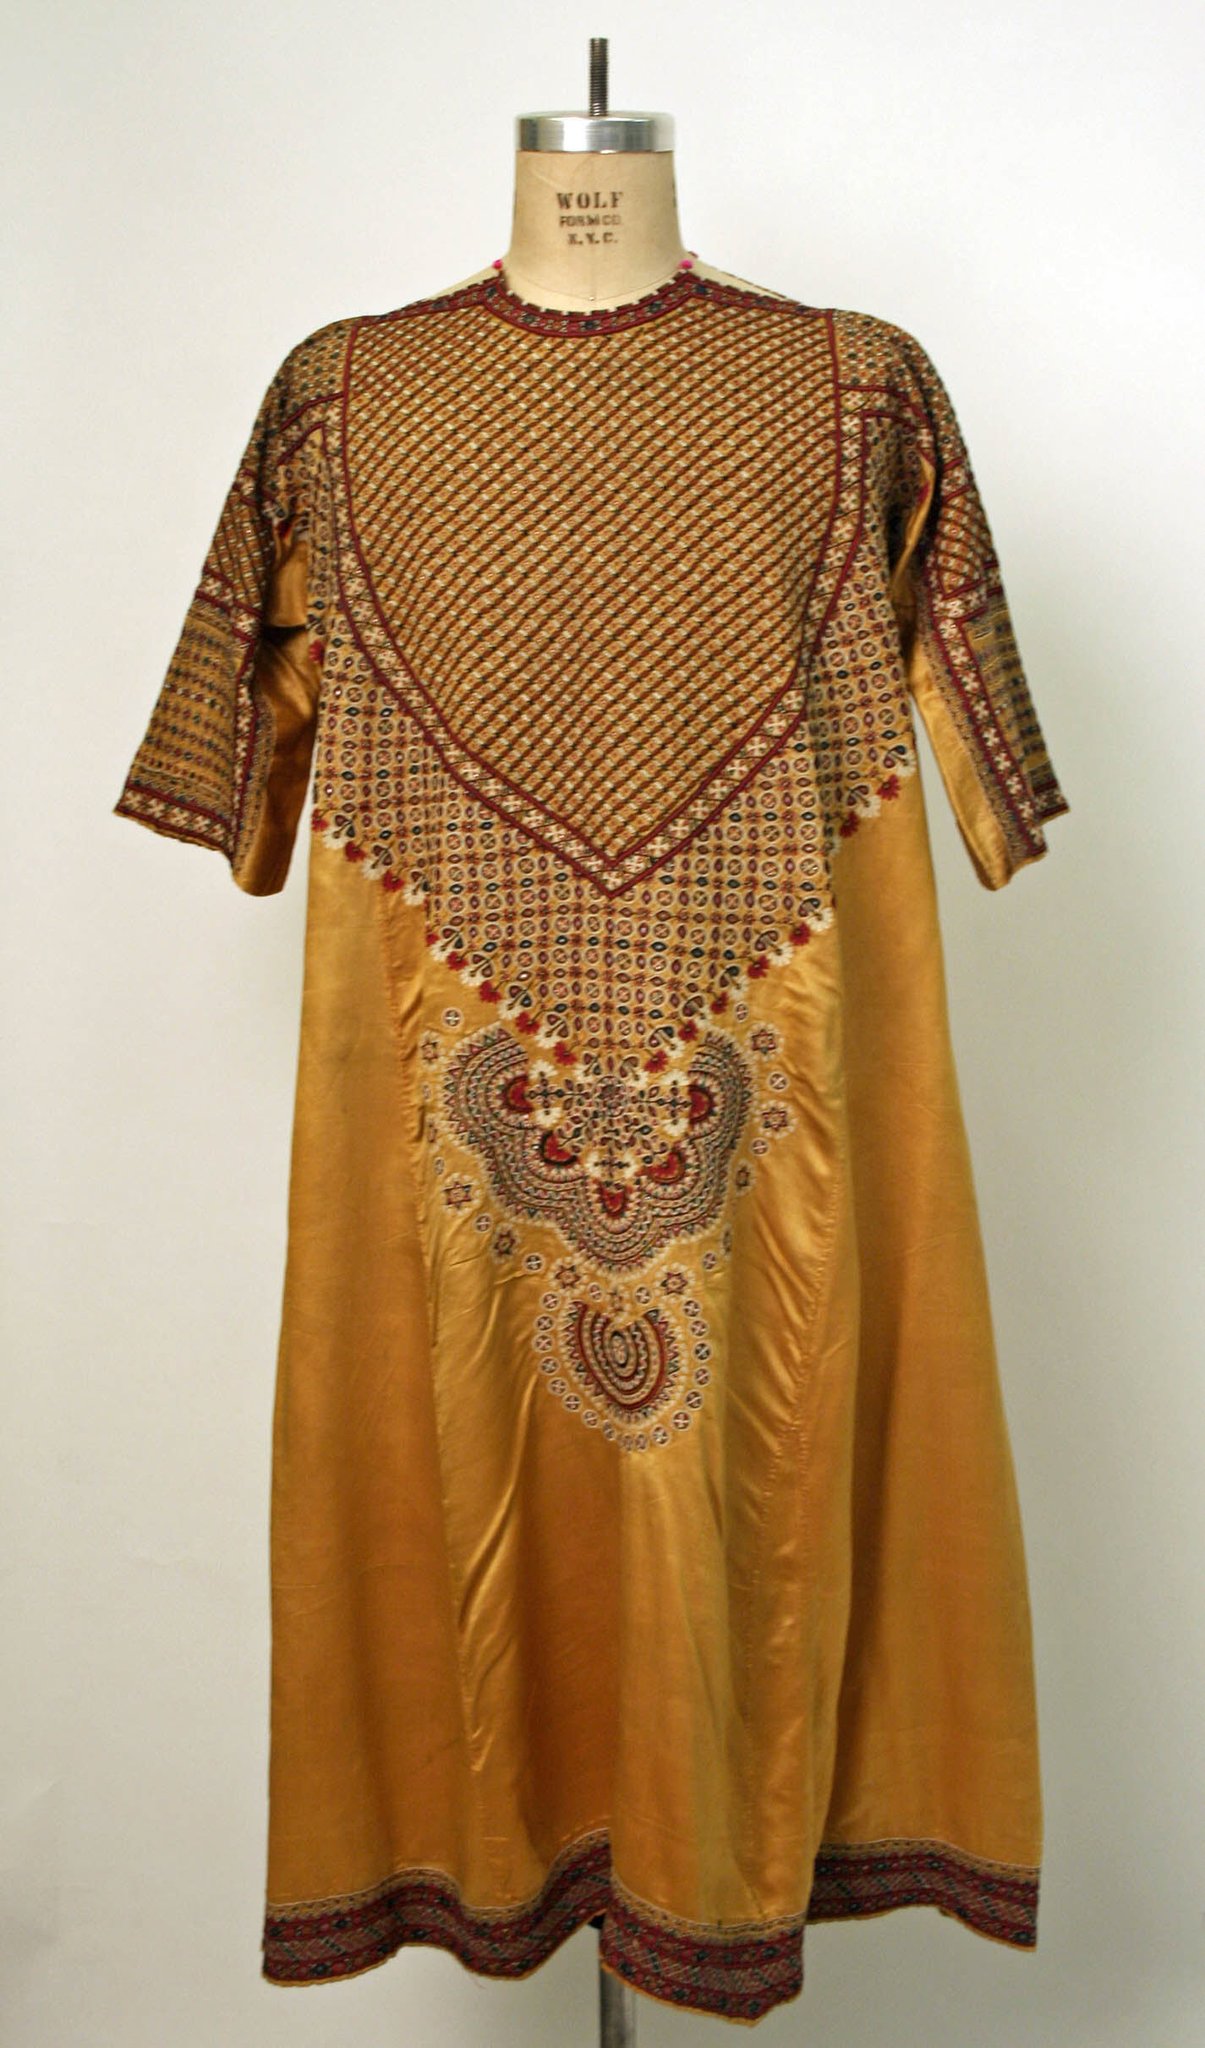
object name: kurta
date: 1801-1900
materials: silk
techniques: embroidery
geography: india